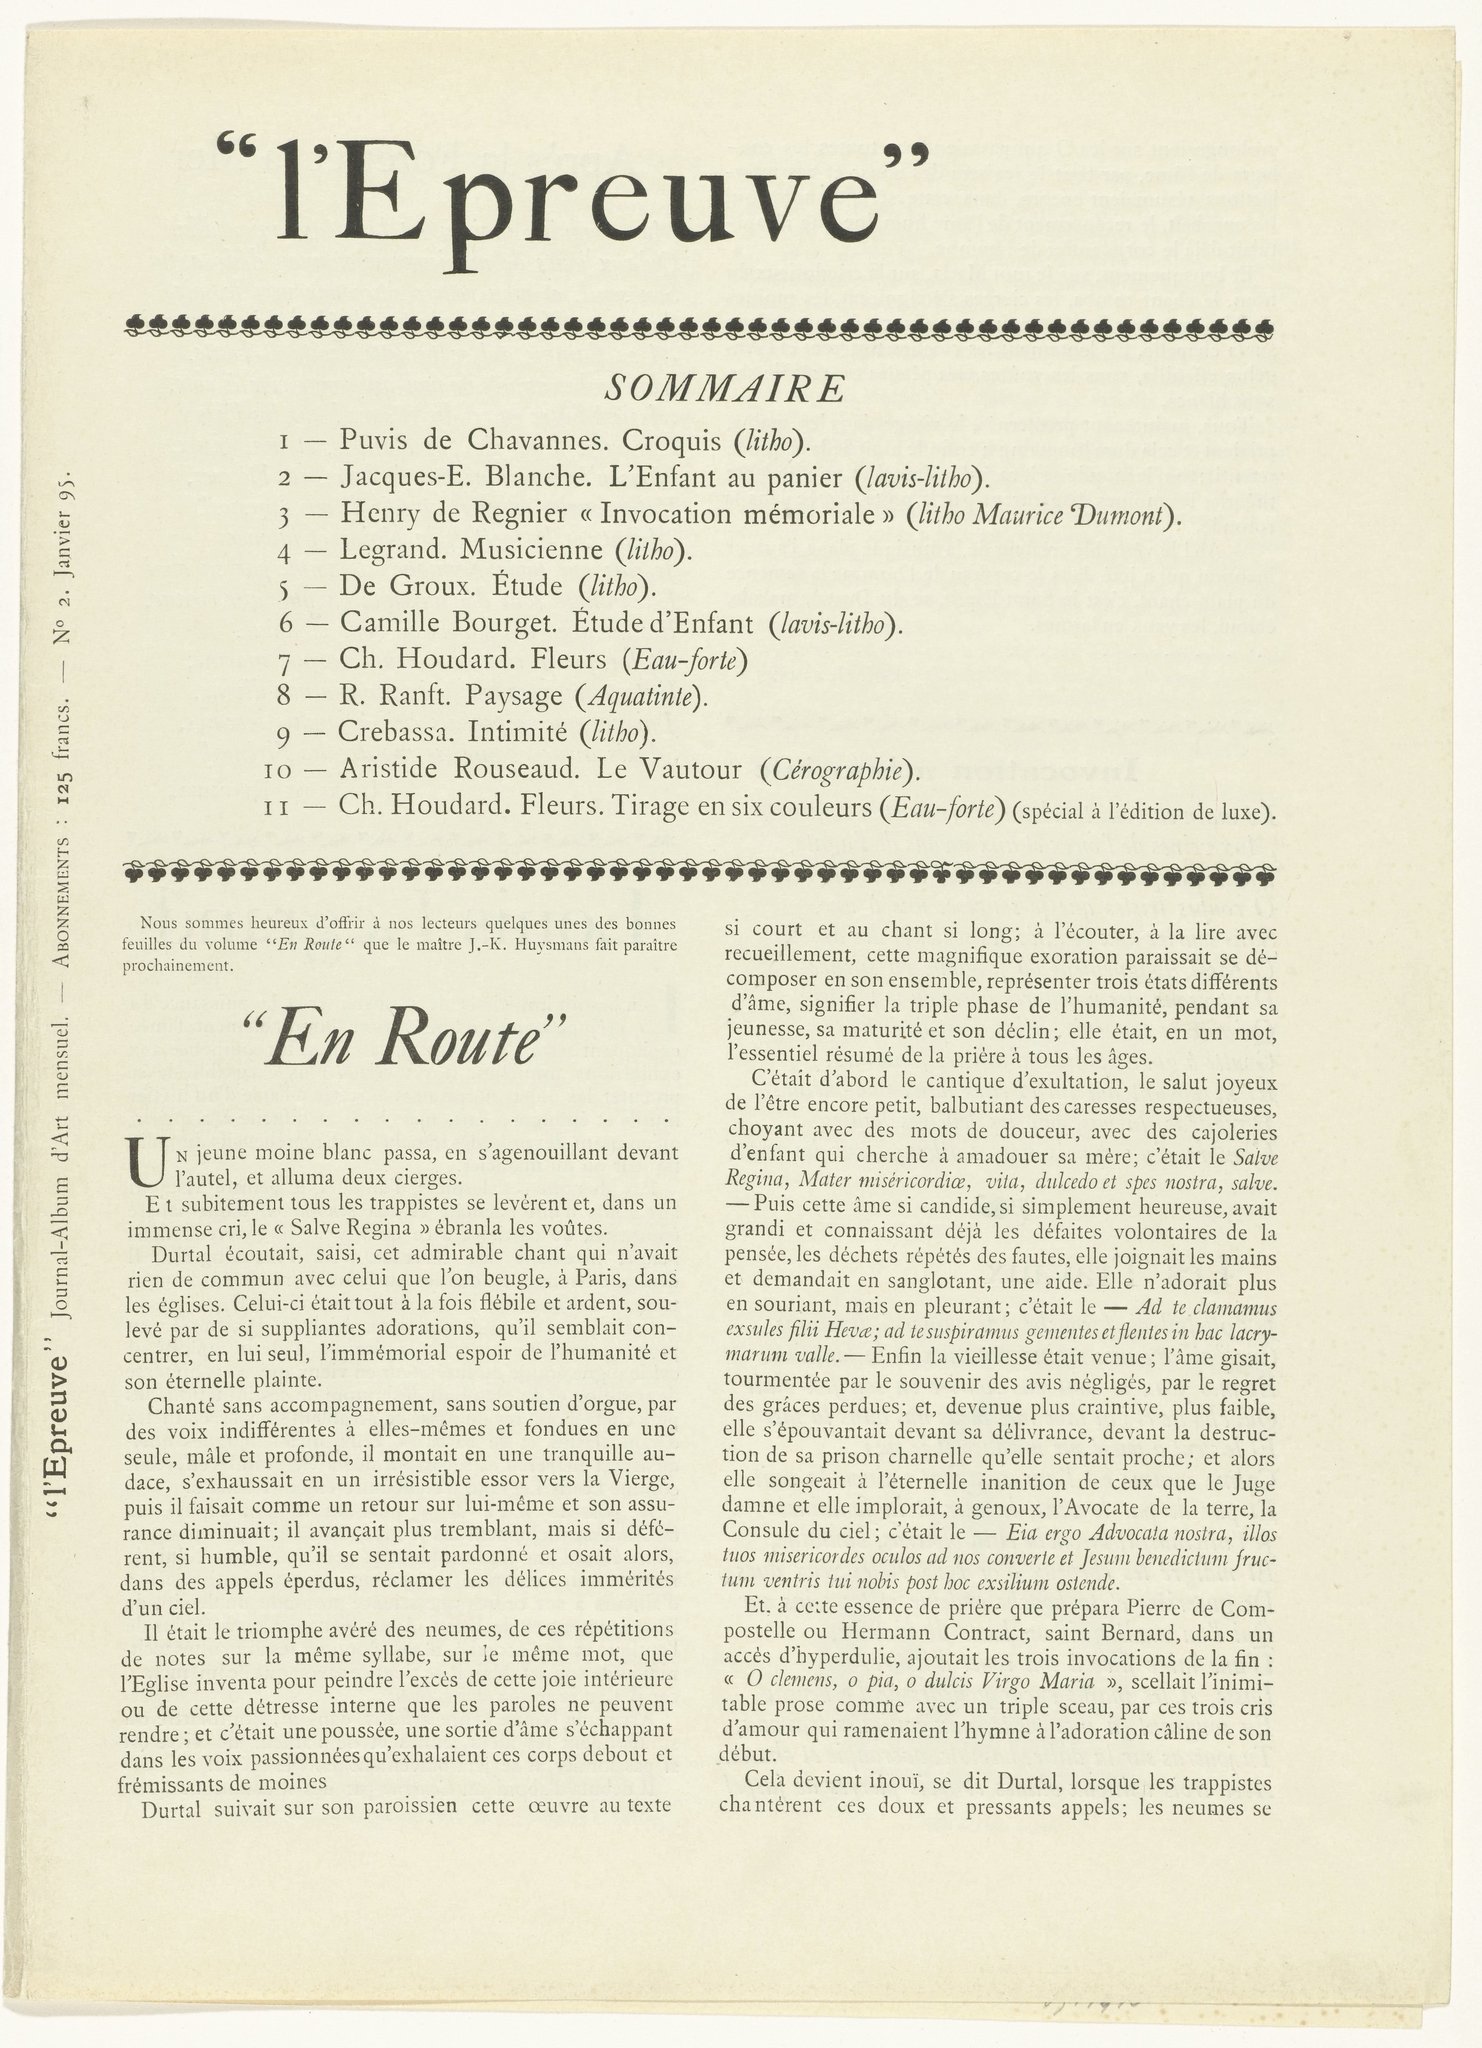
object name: print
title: Tijdschrift L'Epreuve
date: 1895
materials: paper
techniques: lithograph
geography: paris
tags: weekly, monthly, magazine, etc.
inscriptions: collector's mark: Lugt 2760, collector's mark: Lugt 2228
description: Het tijdschrift L'Epreuve verscheen maandelijks van december 1894- december 1895 en besteedde aandacht aan kunst en literatuur. Bij het blad verscheen een album met tien originele prenten van bekende kunstenaars, deze worden op de voorpagina genoemd. In deze tweede uitgave van januari 1895 staat onder andere een artikel over de kunstenaar Louis Legrand en een illustratie van zijn werk en twee gedichten van Henri de Régnier.